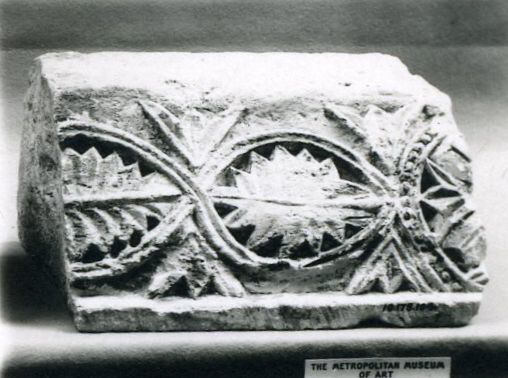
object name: fragment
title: Fragment of Molding with a Pattern of Interlaced Acanthus Leaves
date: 501-600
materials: limestone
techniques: carving, relief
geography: egypt